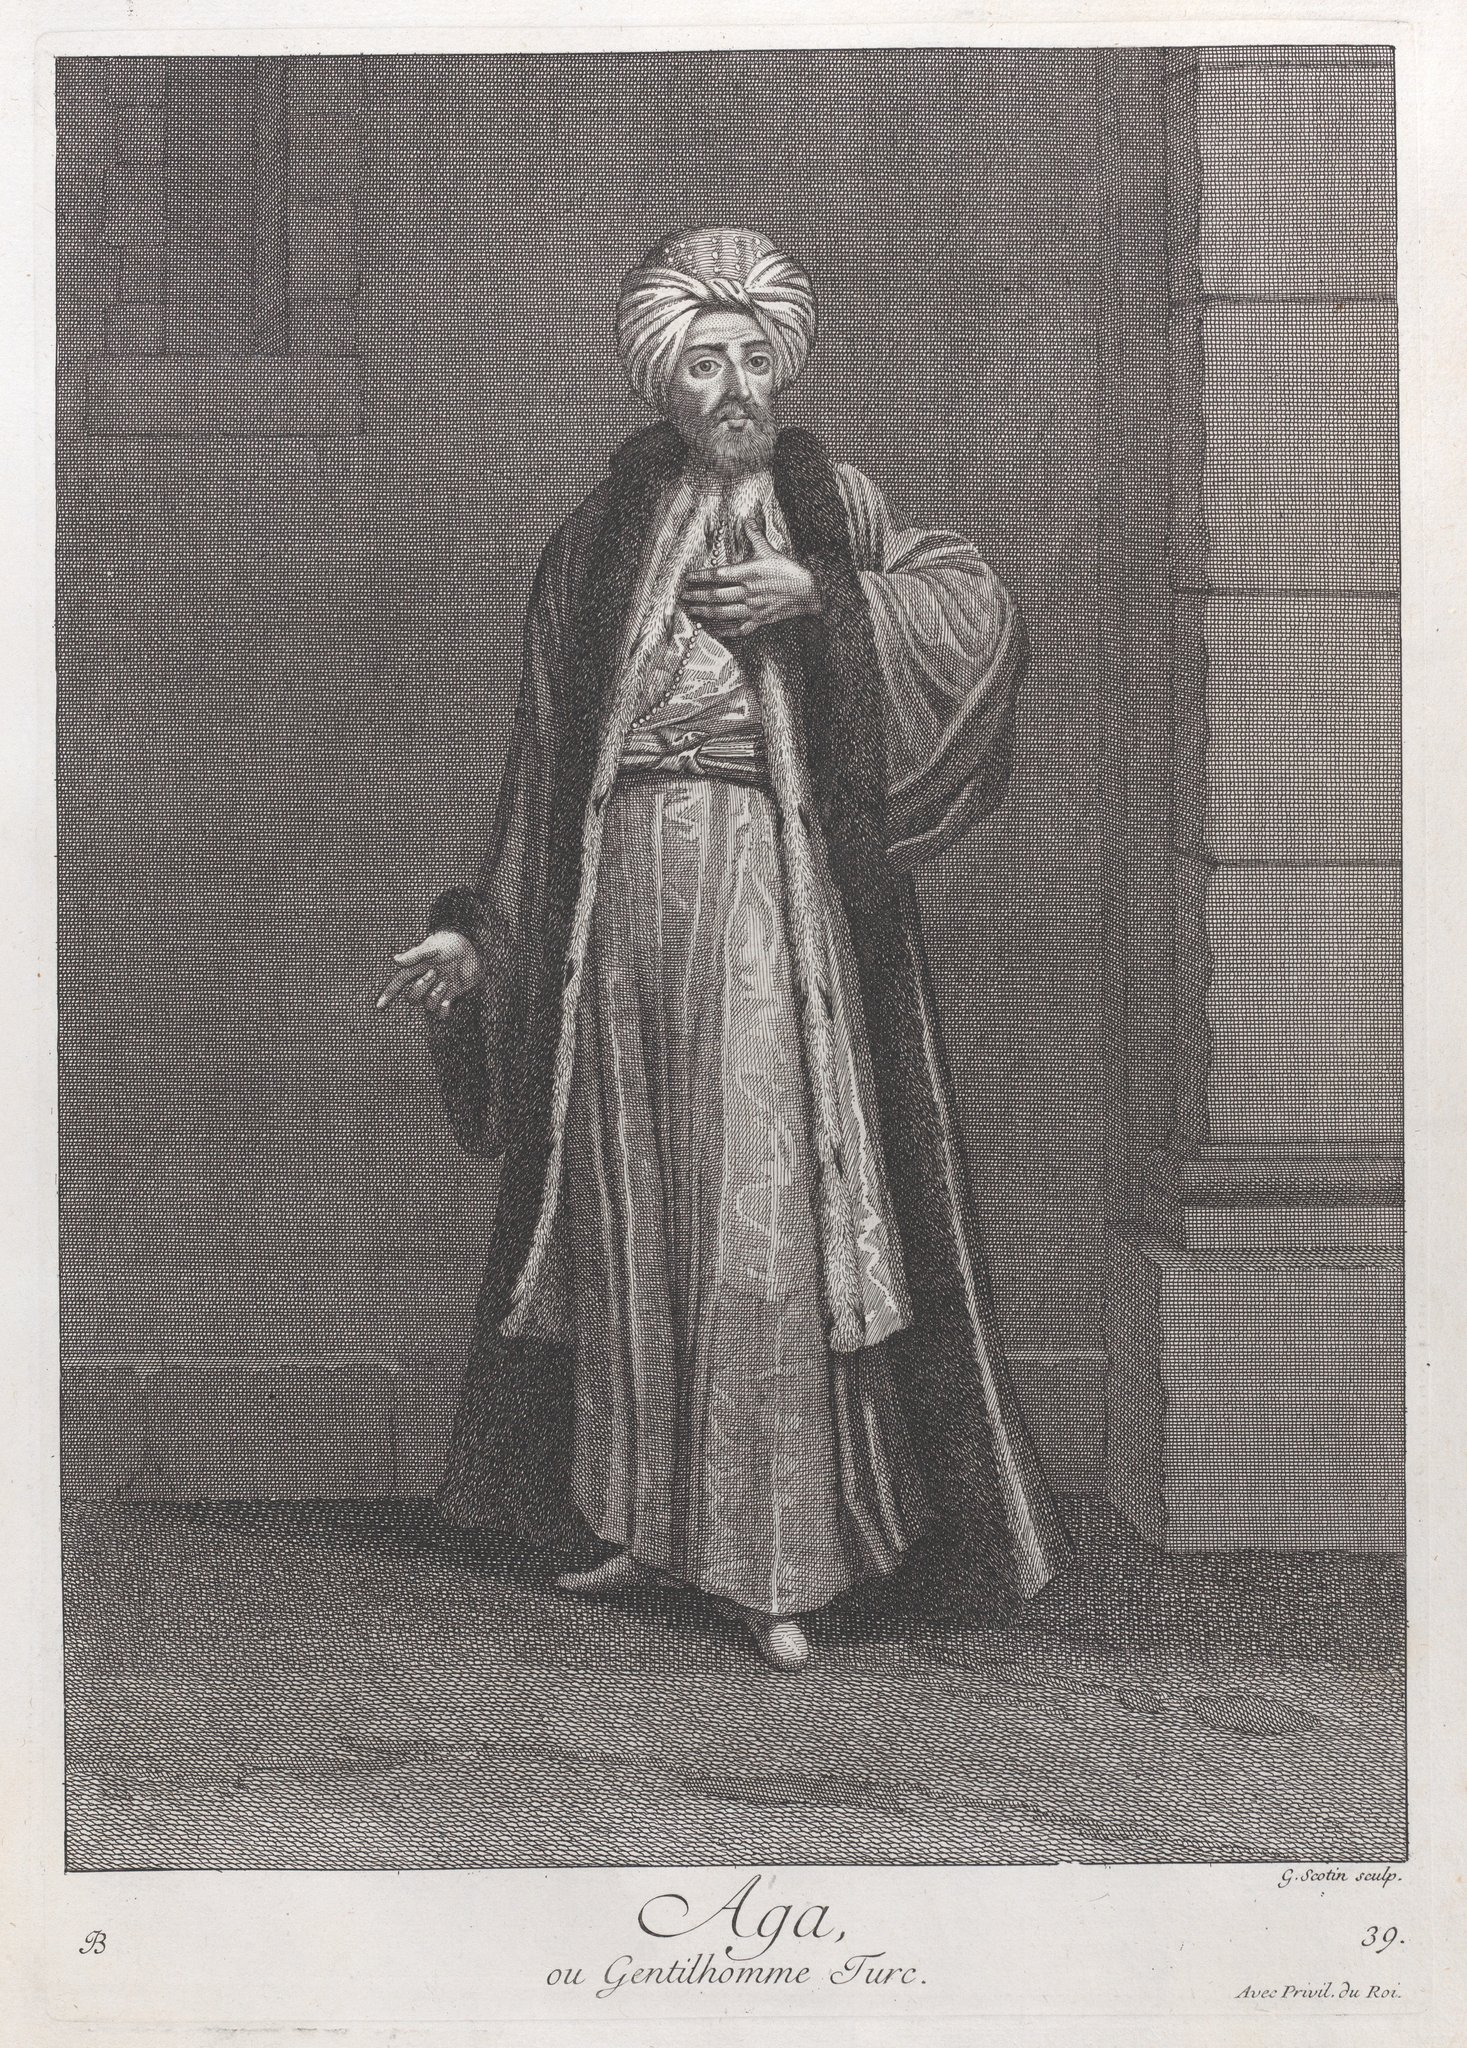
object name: print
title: Aga, ou Gentilhomme Turc, plate 39 from "Recueil de cent estampes représentent differentes nations du Levant"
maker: jean baptiste vanmour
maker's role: artist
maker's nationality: french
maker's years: 1671-1737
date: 1714-1715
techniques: engraving, etching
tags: men